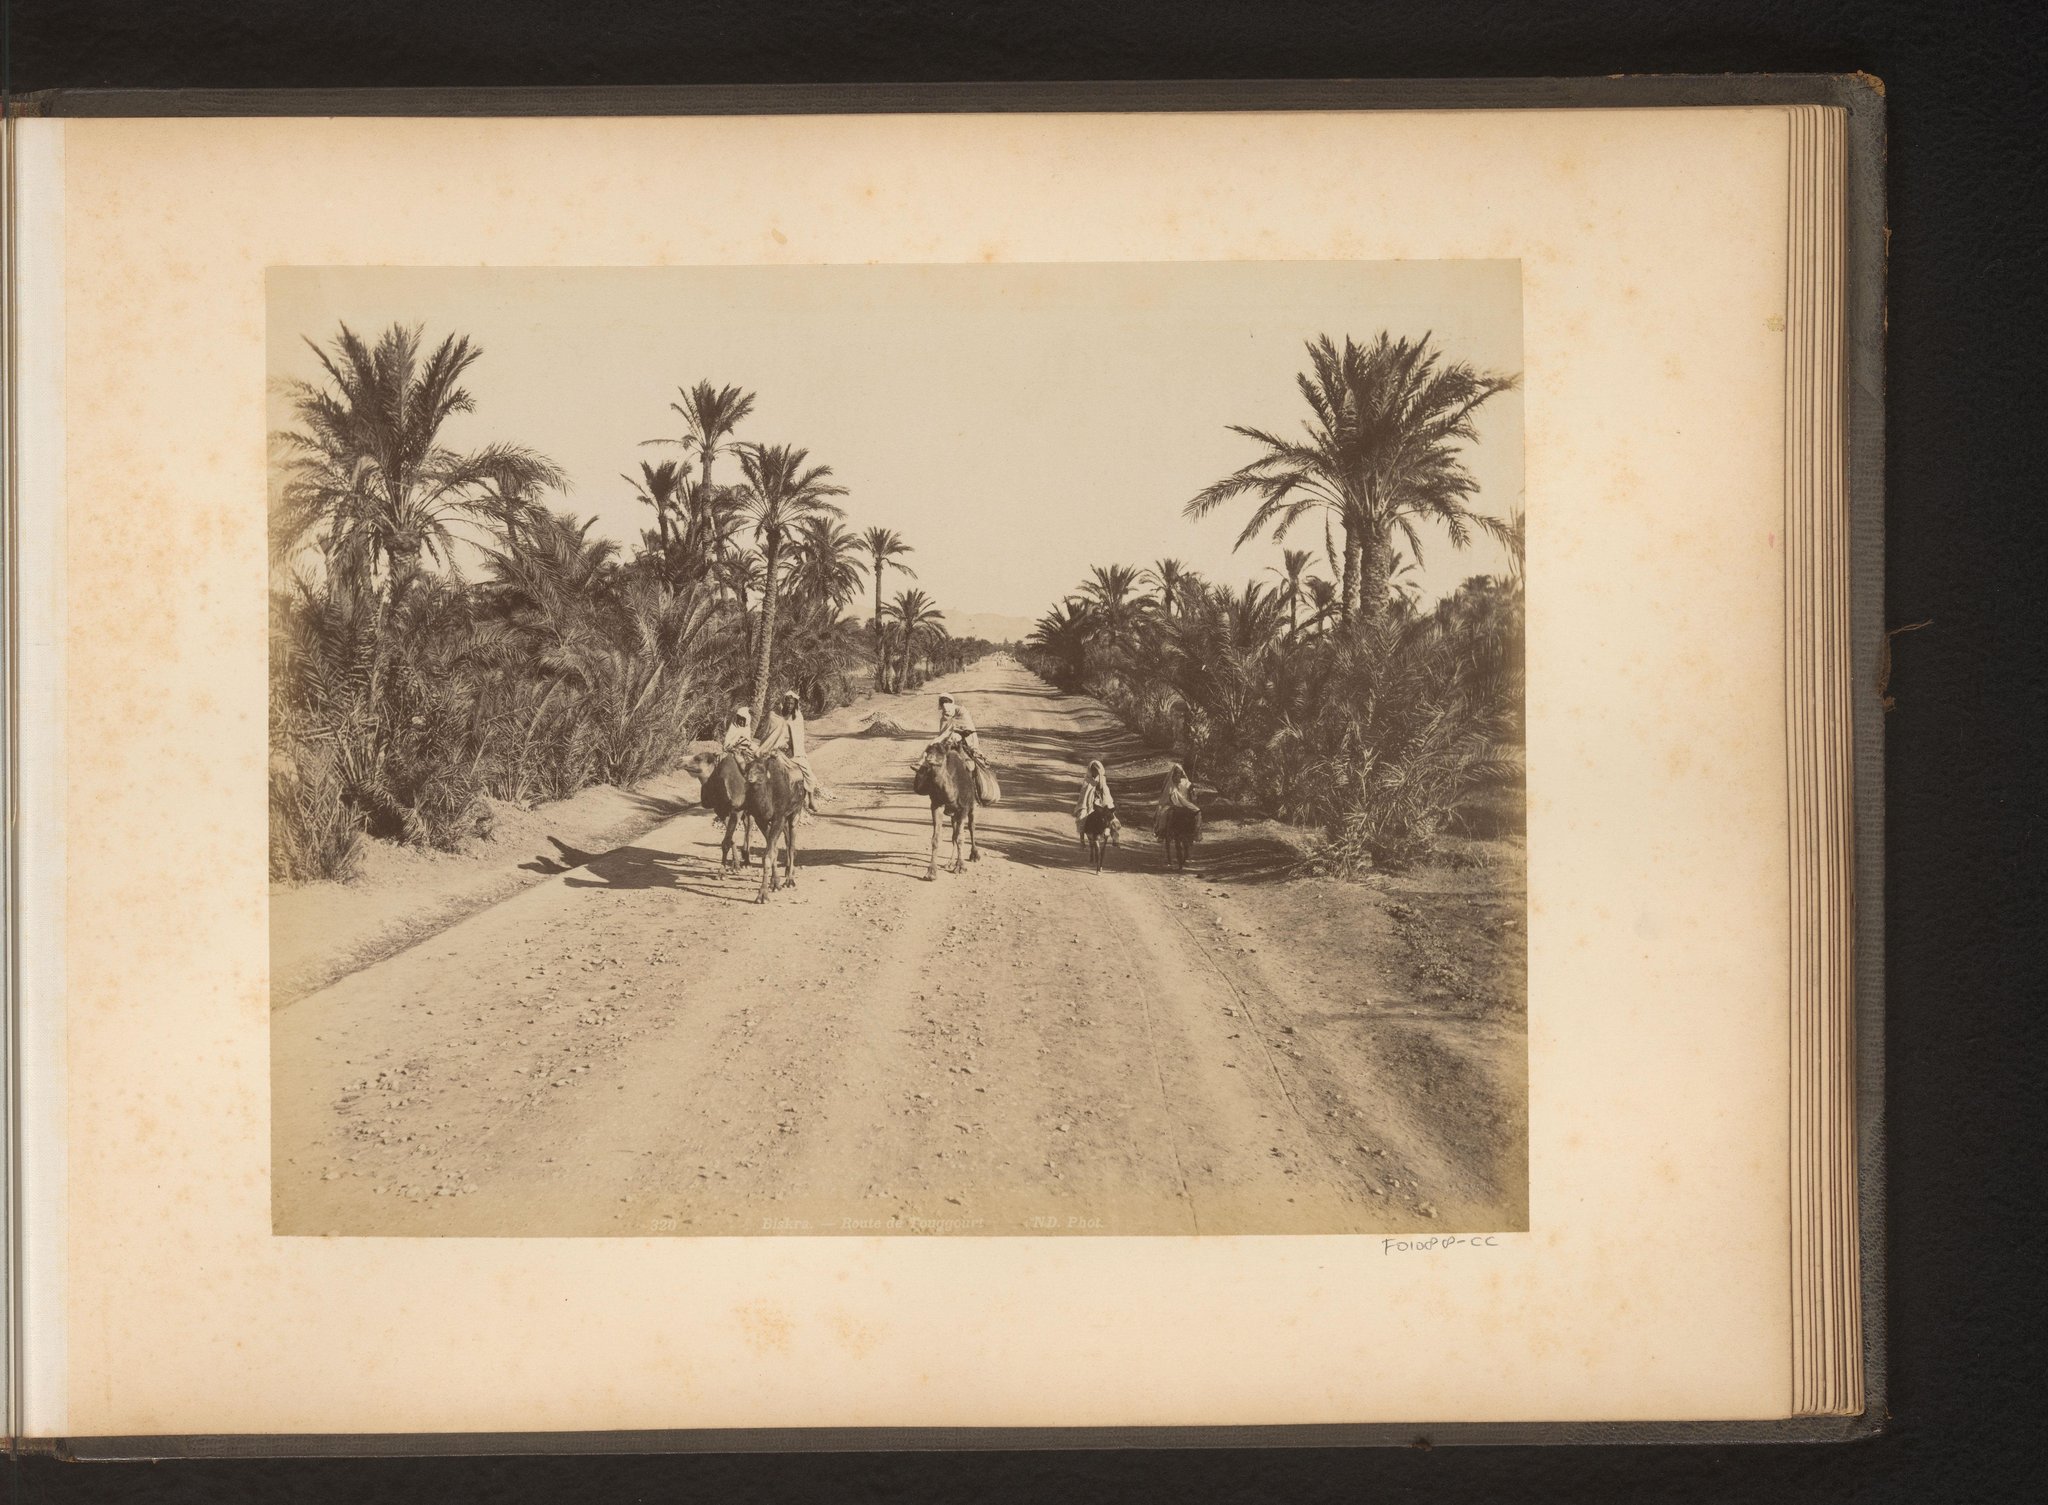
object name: photograph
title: Personen rijdend op dromedarissen en ezels in de omgeving van Biskra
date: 1880-1900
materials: photographic support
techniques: albumen print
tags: hoofed animals: dromedary, ass, donkey, historical persons, riding on animal other than horse, ass, or mule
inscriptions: check stamp: ‘J. Kuhn Editeur/ 220 Rue de Rivoli Paris’, number: ‘320’